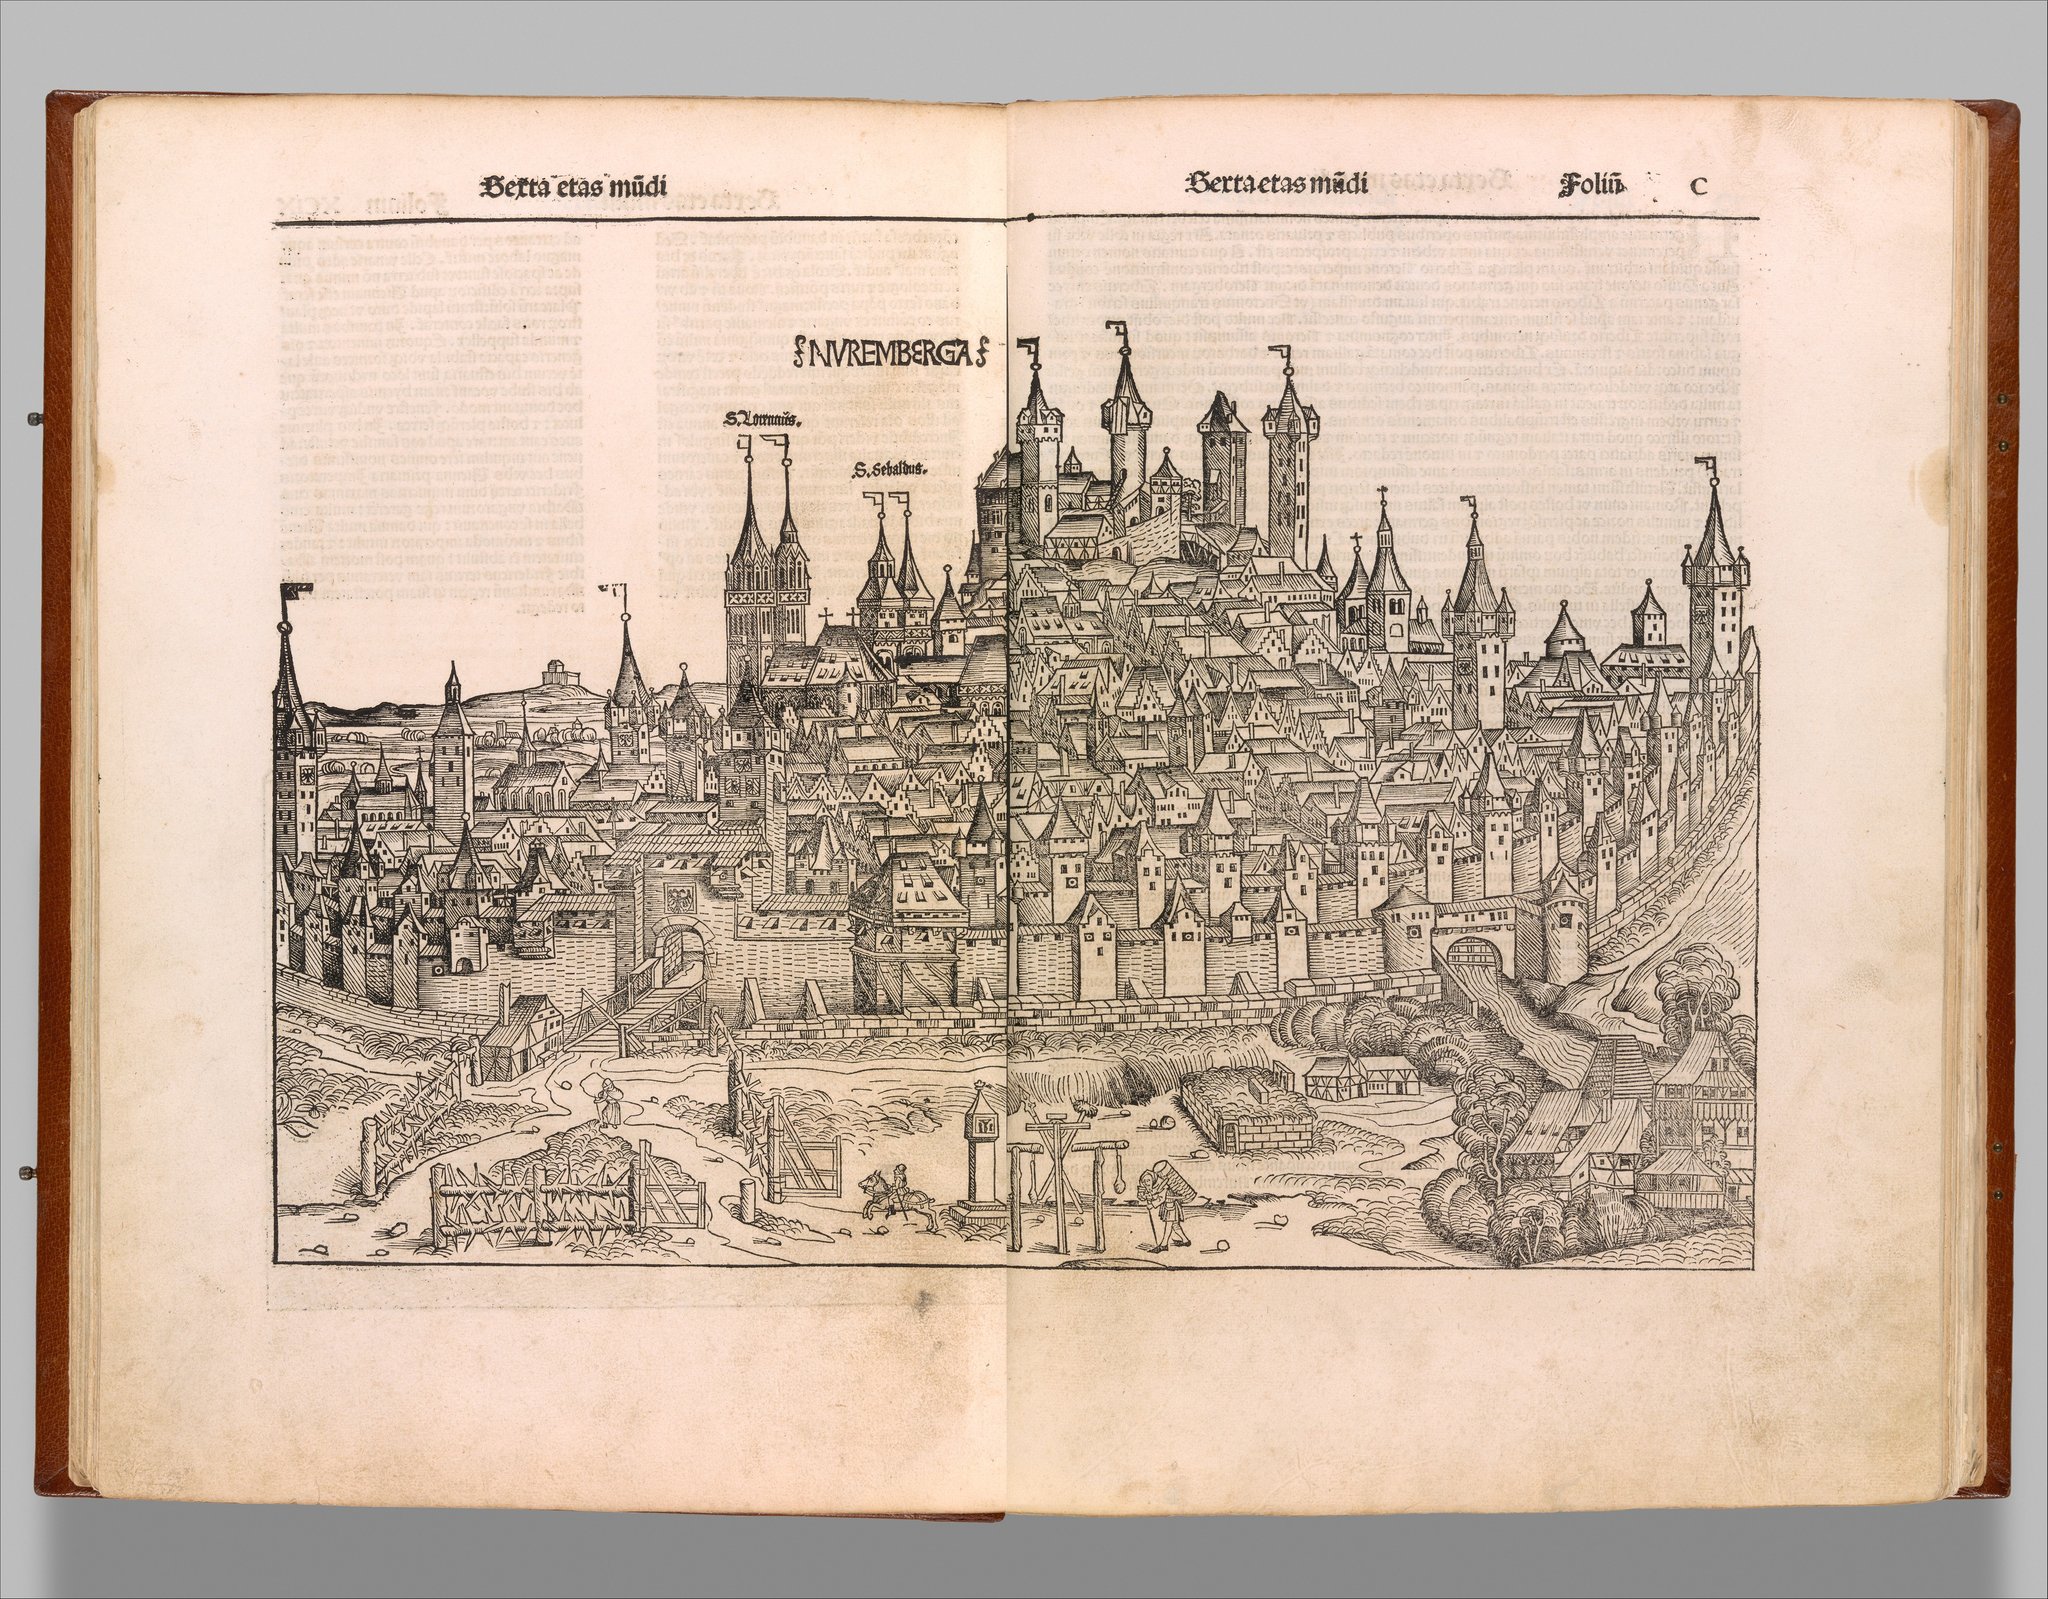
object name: book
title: Registrum huius Operis libri cronicarum cum figuris et ymagibus ab inicio mundi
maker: hartmann schedel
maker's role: author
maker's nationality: german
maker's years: 1440-1514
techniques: woodcut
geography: germany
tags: buildings,cities